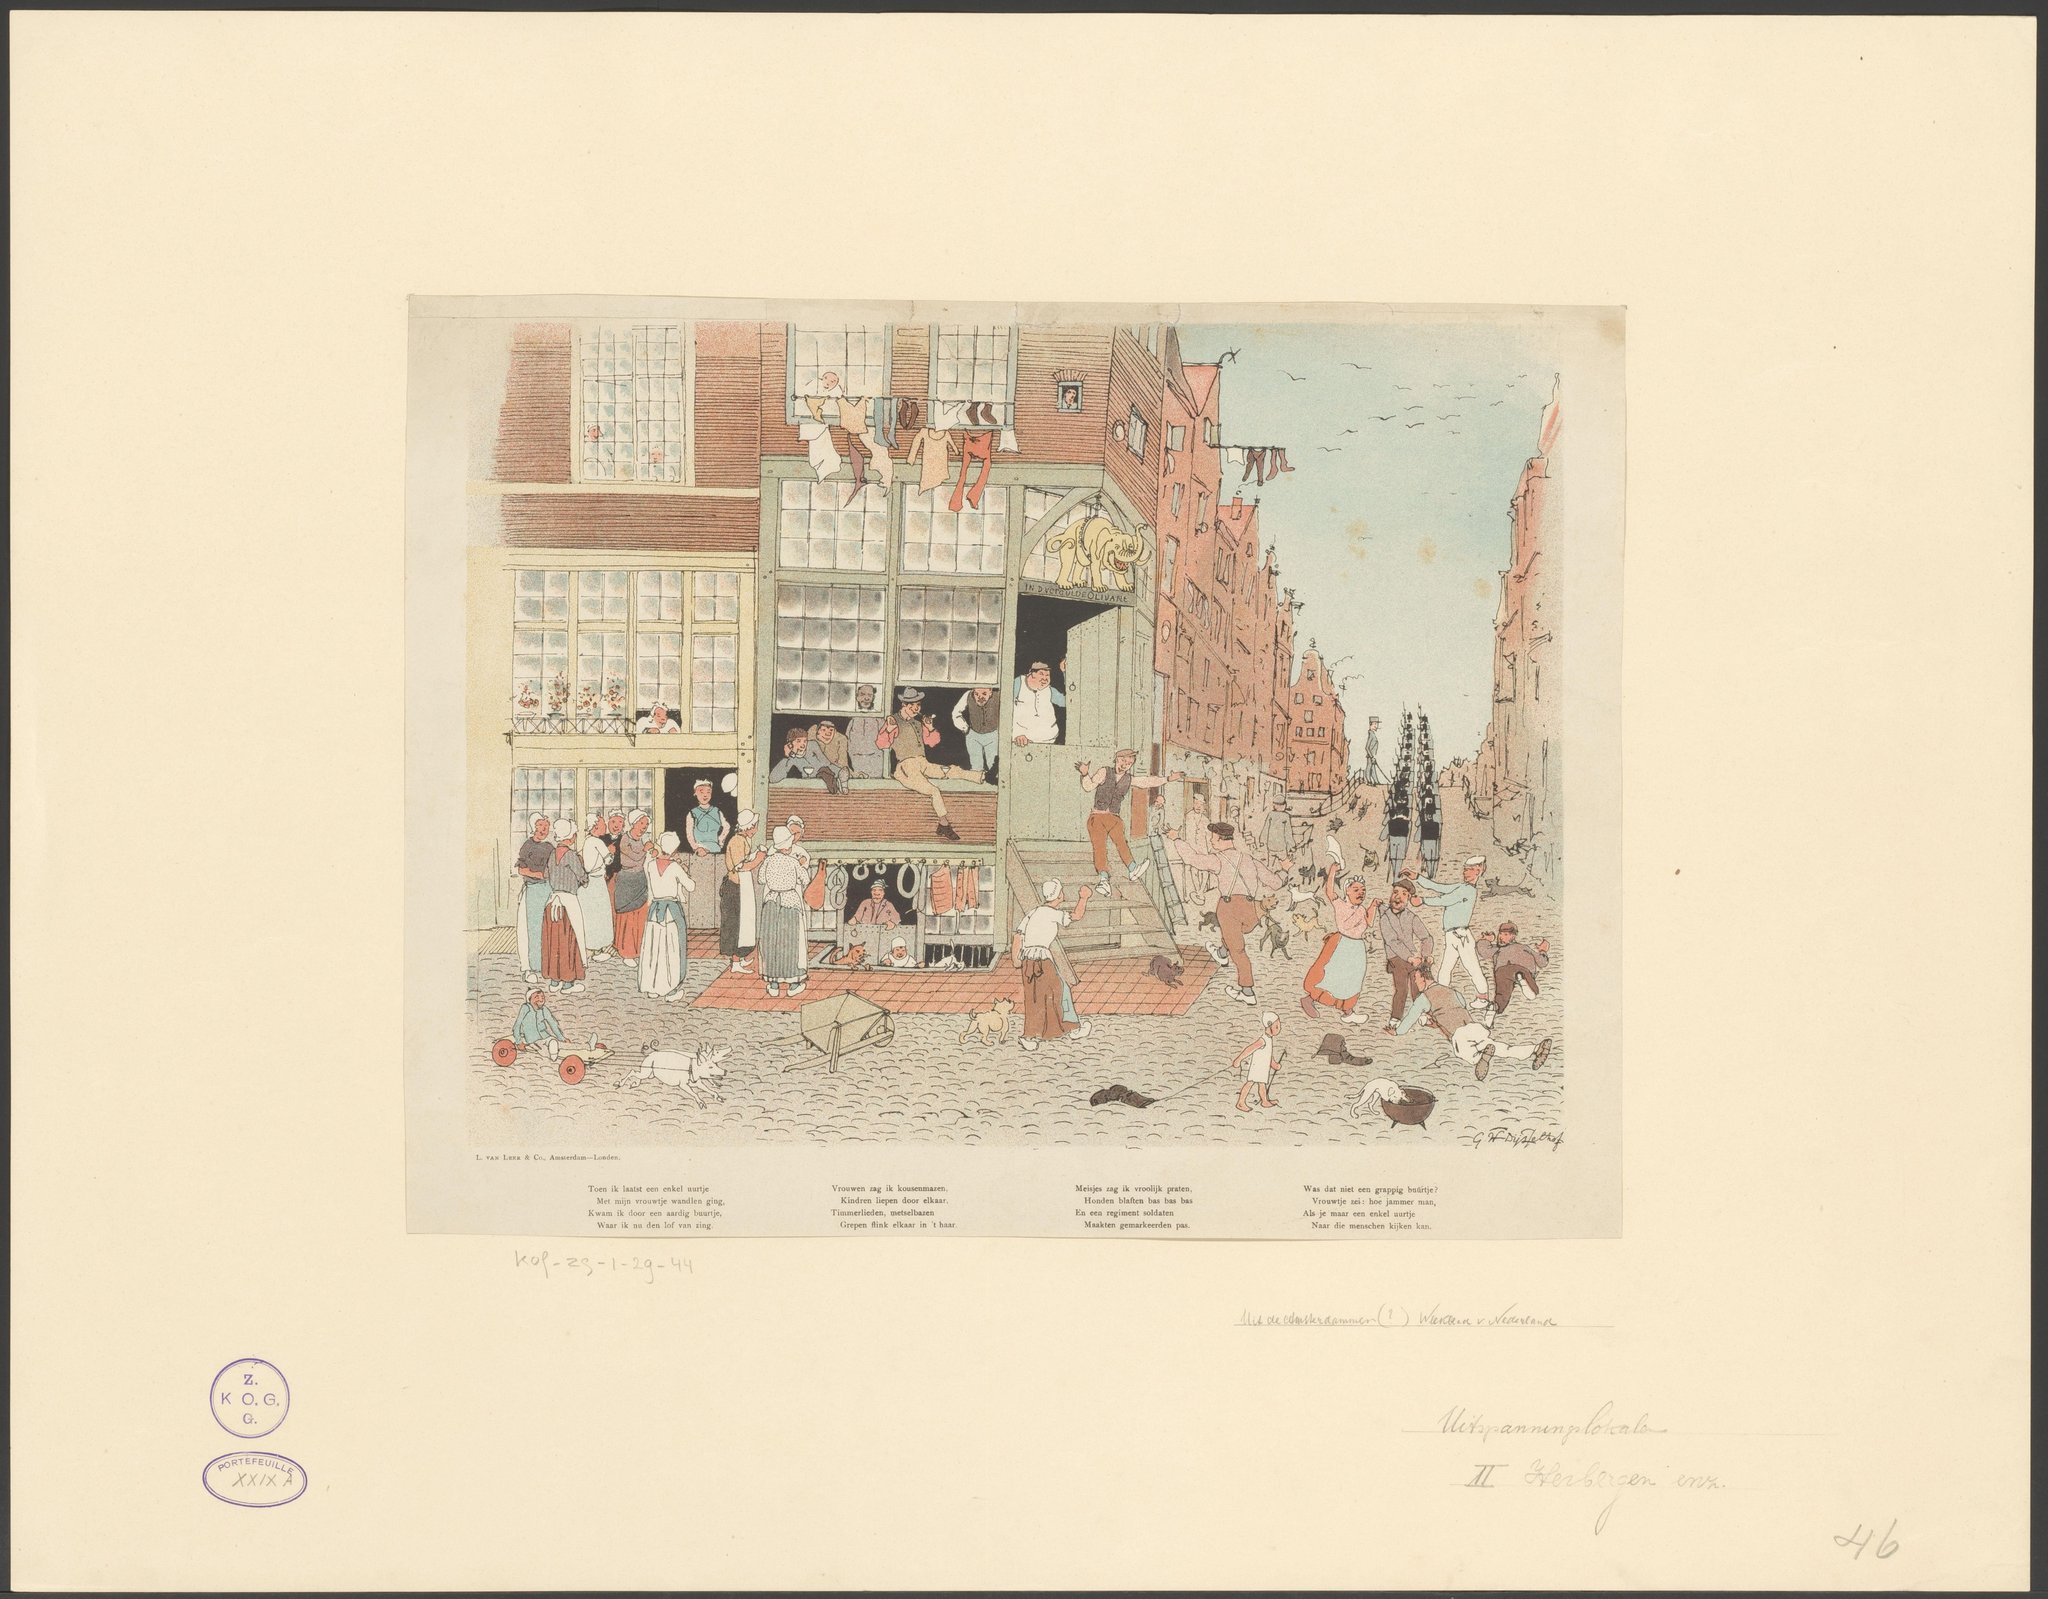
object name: print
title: Stadsgezicht met mannen, vrouwen en kinderen in klederdracht rondom het café 'In de vergulde olivant'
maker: gerrit willem dijsselhof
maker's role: designer, draughtsman, print maker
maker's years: 1866-1924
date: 1891-1924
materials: paper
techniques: letterpress printing, lithograph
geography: london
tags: inn, coffee-house, public house, etc., butcher, slaughterman, public road, amsterdam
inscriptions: stamp, collector's mark: Lugt 1641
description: Mannen, vrouwen en kinderen in klederdracht rondom het café 'In de vergulde olivant' op de hoek van een straat. Onder het café een slagerij. Links een kind op een kar die door twee varkens wordt voortgetrokken. Rechts een groep vechtende mannen en vrouwen. Achter hen rennende honden en een regiment marcherende soldaten. Onderwerpsrubrieken binnen de Atlas Zeden en Gewoonten: Zeden en gewoonten in engeren zin, Volksleven, Uitspanningslokalen, Koffiehuizen.